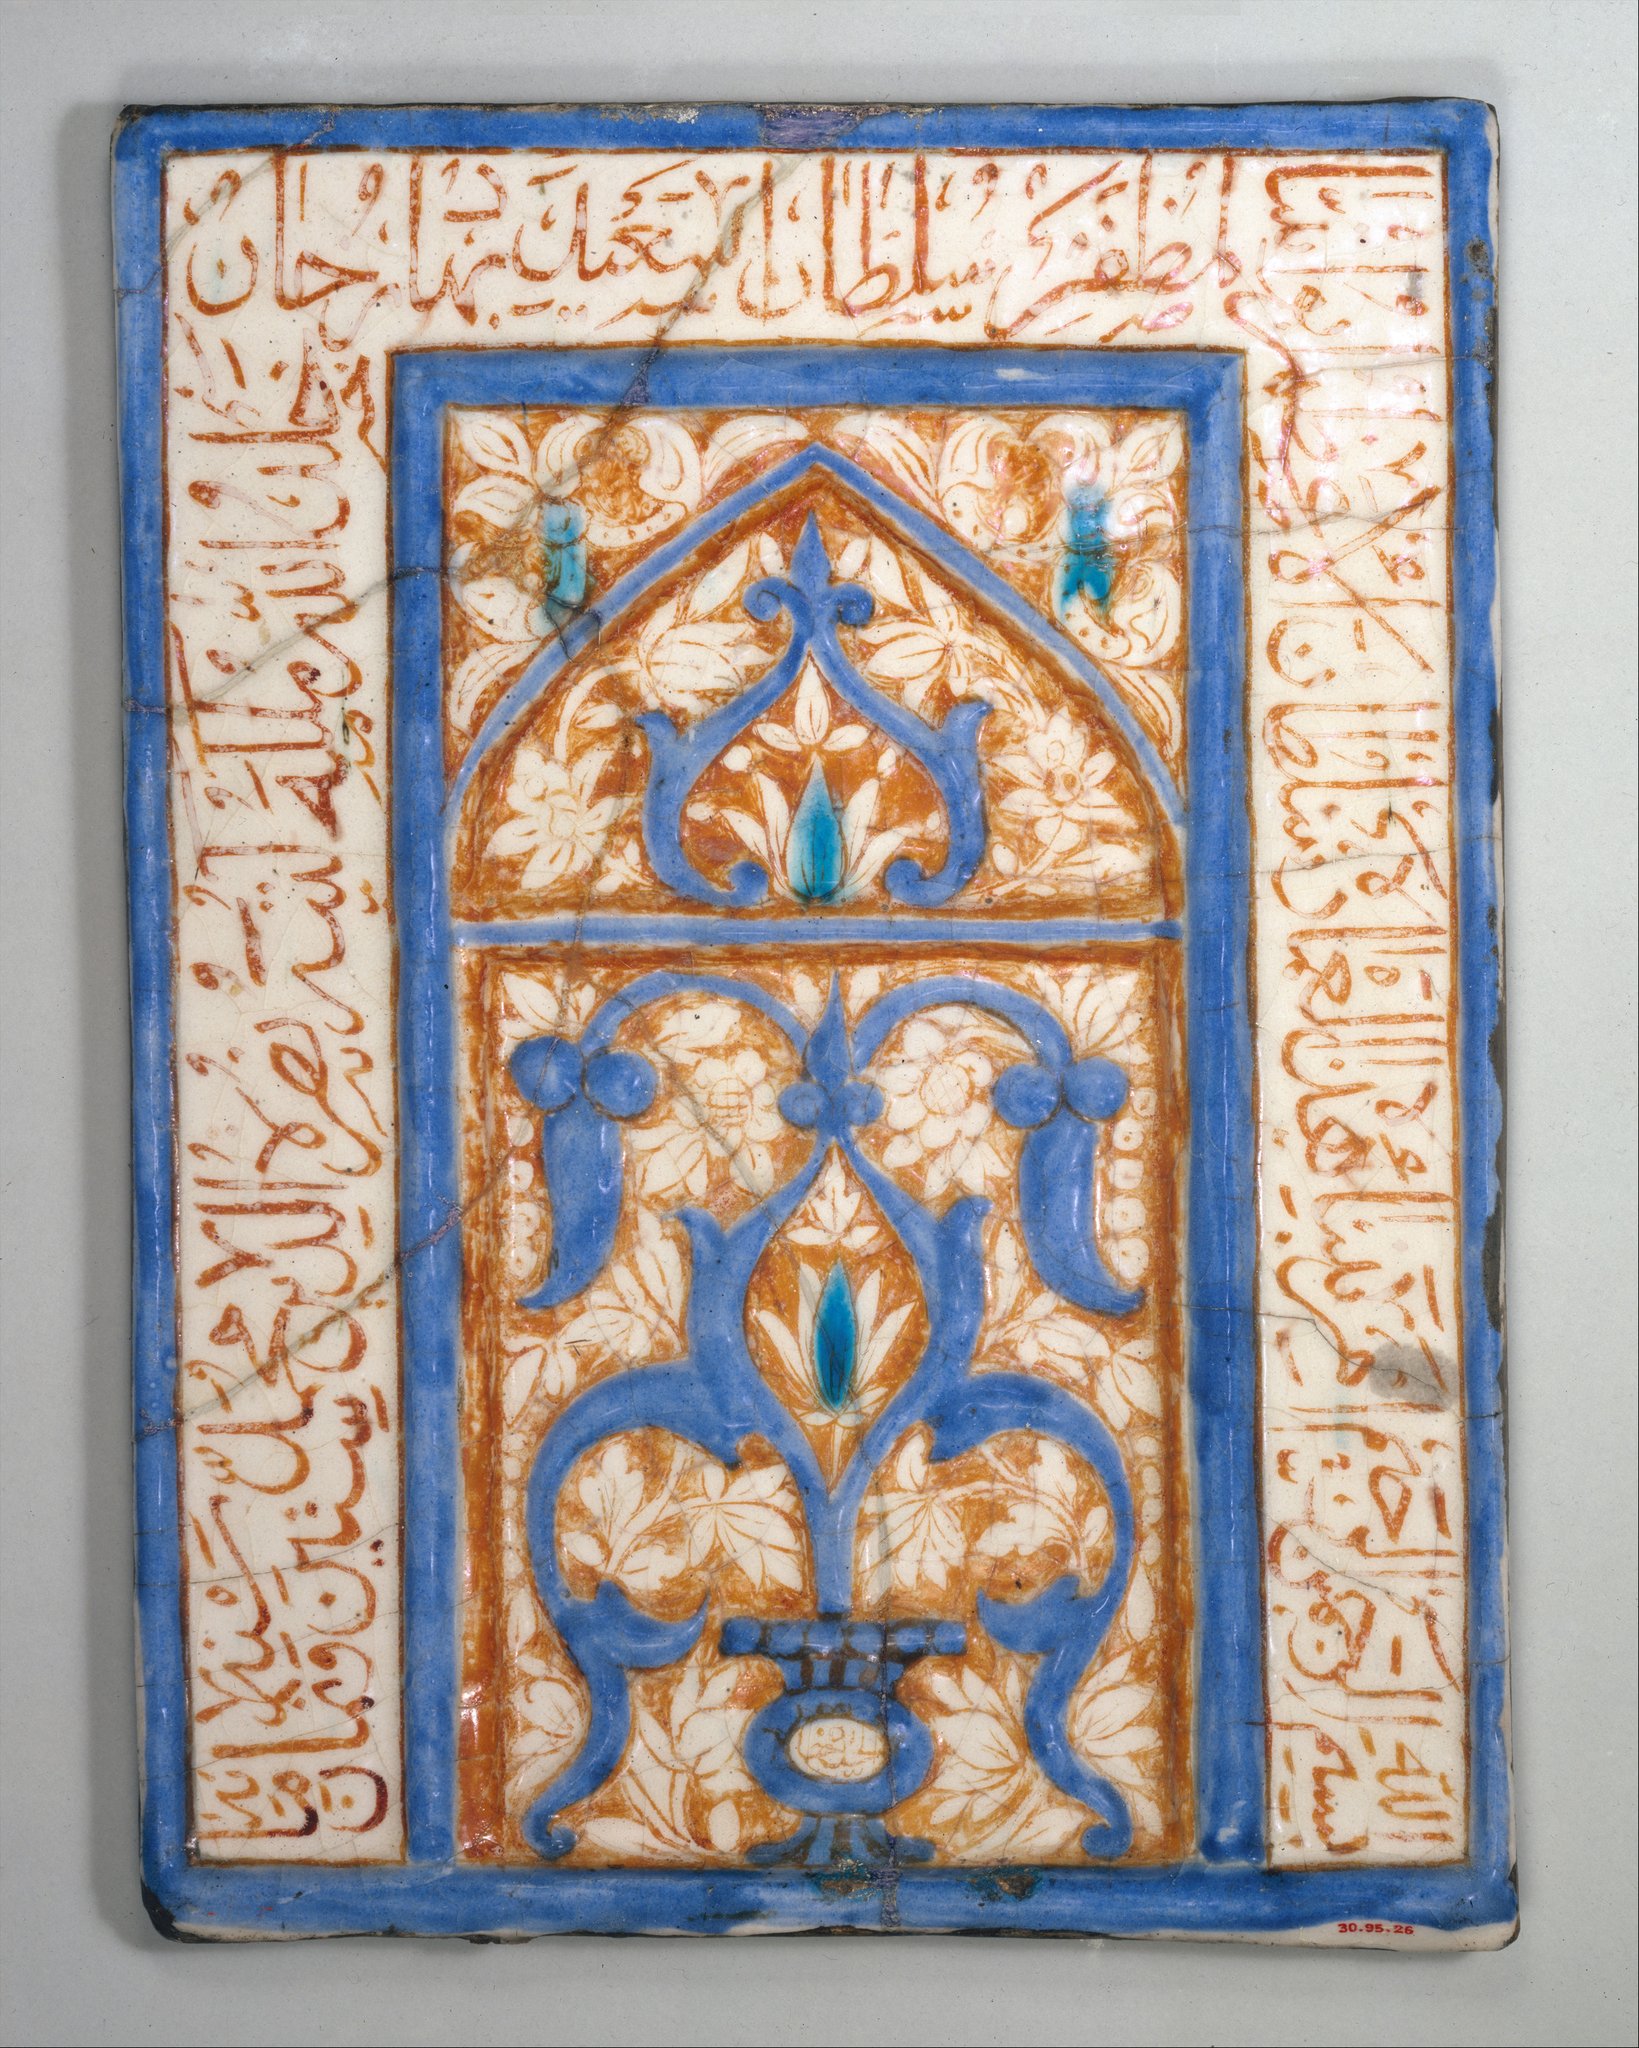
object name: tile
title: Tile with Niche Design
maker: nusrat al-din muhammad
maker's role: calligrapher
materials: glaze, stonepaste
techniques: luster painting, painting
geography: iran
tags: arabic